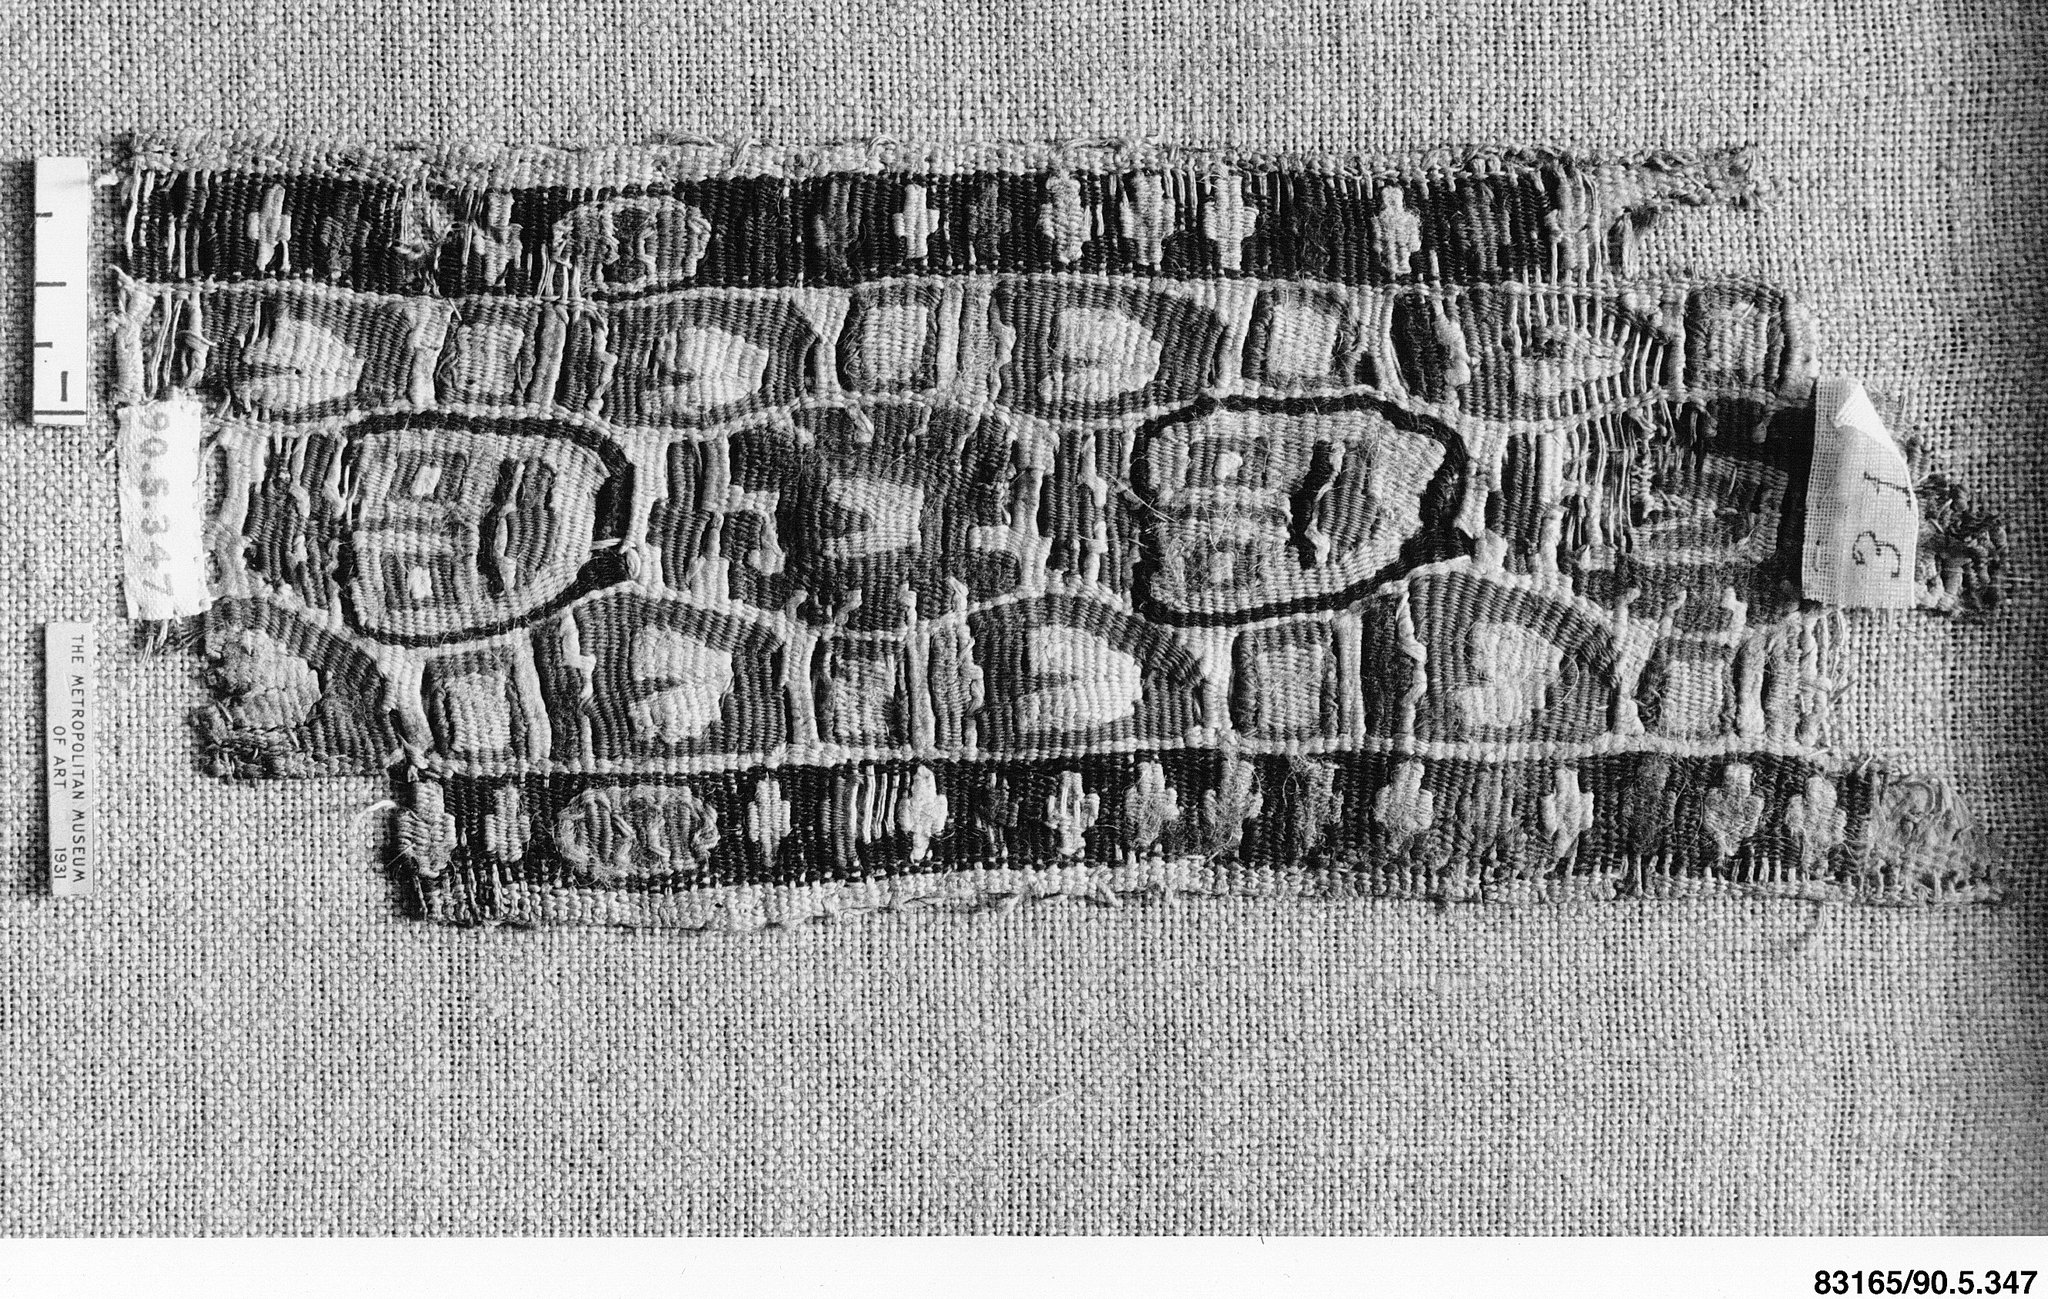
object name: textile fragment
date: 401-600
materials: linen, wool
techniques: weave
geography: egypt